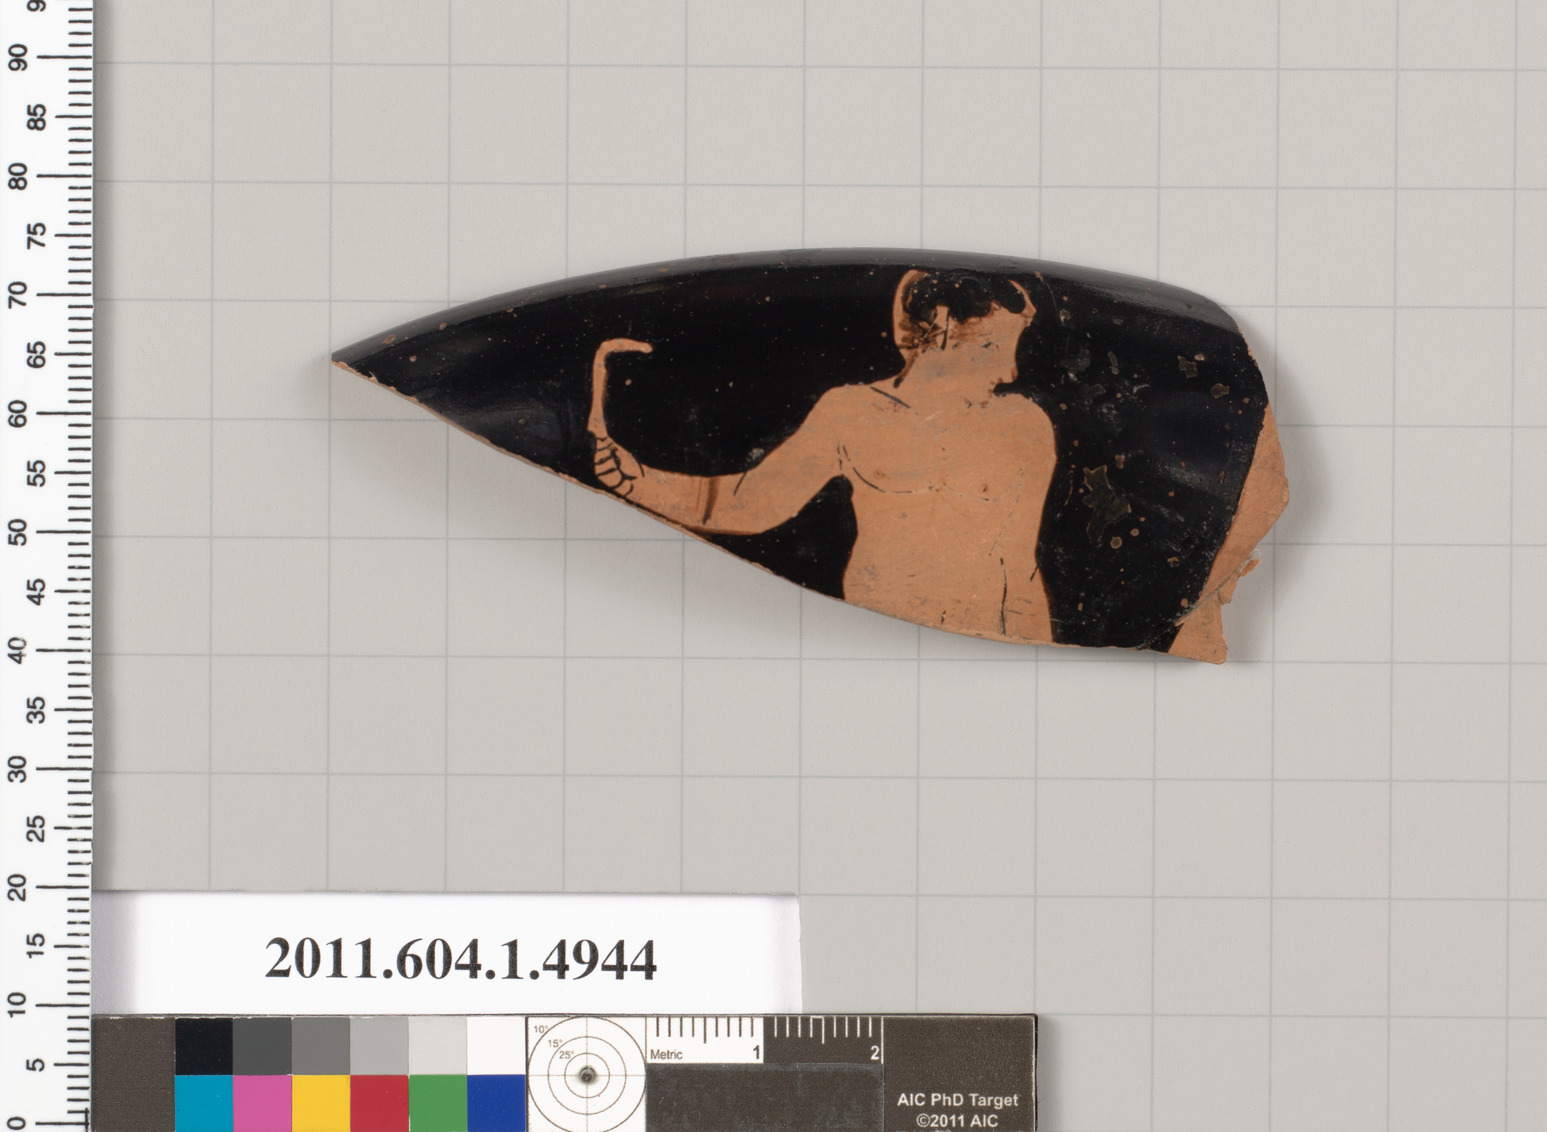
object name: kylix fragment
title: Terracotta rim fragment of a kylix (drinking cup)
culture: greek, attic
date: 460-450 BCE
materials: terracotta